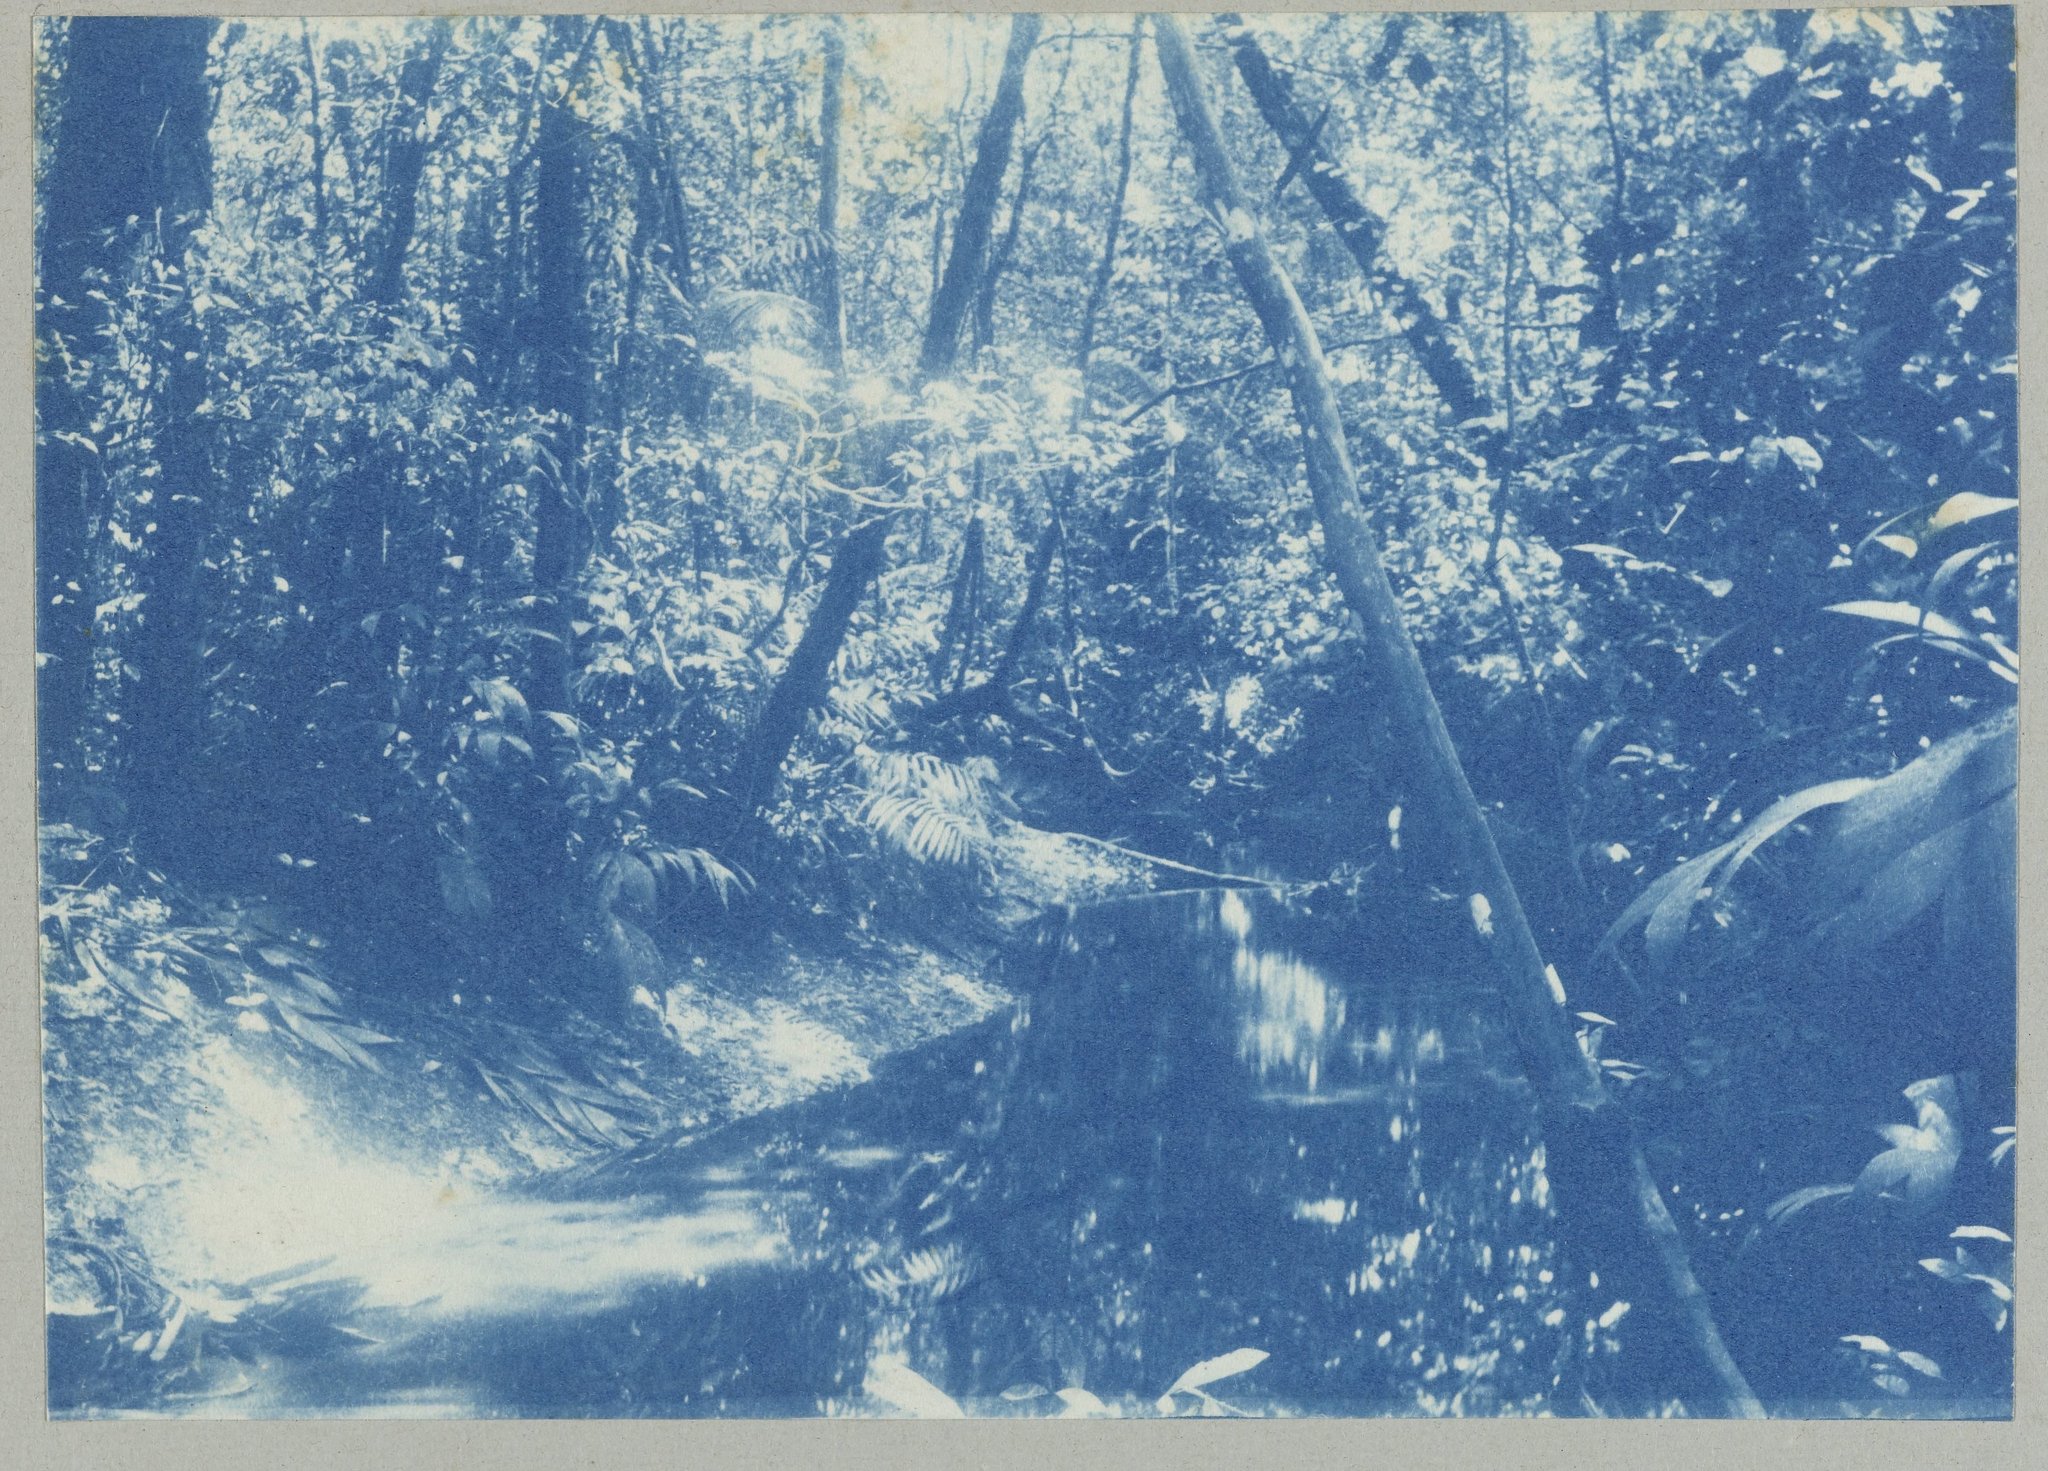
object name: photograph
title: Maboegoesoe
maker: hendrik doijer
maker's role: engineer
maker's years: 1863-1925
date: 1903-1910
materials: photographic support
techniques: cyanotype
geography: suriname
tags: suriname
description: Gezicht in het oerwoud bij Maboegoesoe. Onderdeel van het fotoalbum Souvenir de Voyage (deel 1), over het leven van de familie Doijer in en rond de plantage Ma Retraite in Suriname in de jaren 1903-1910.